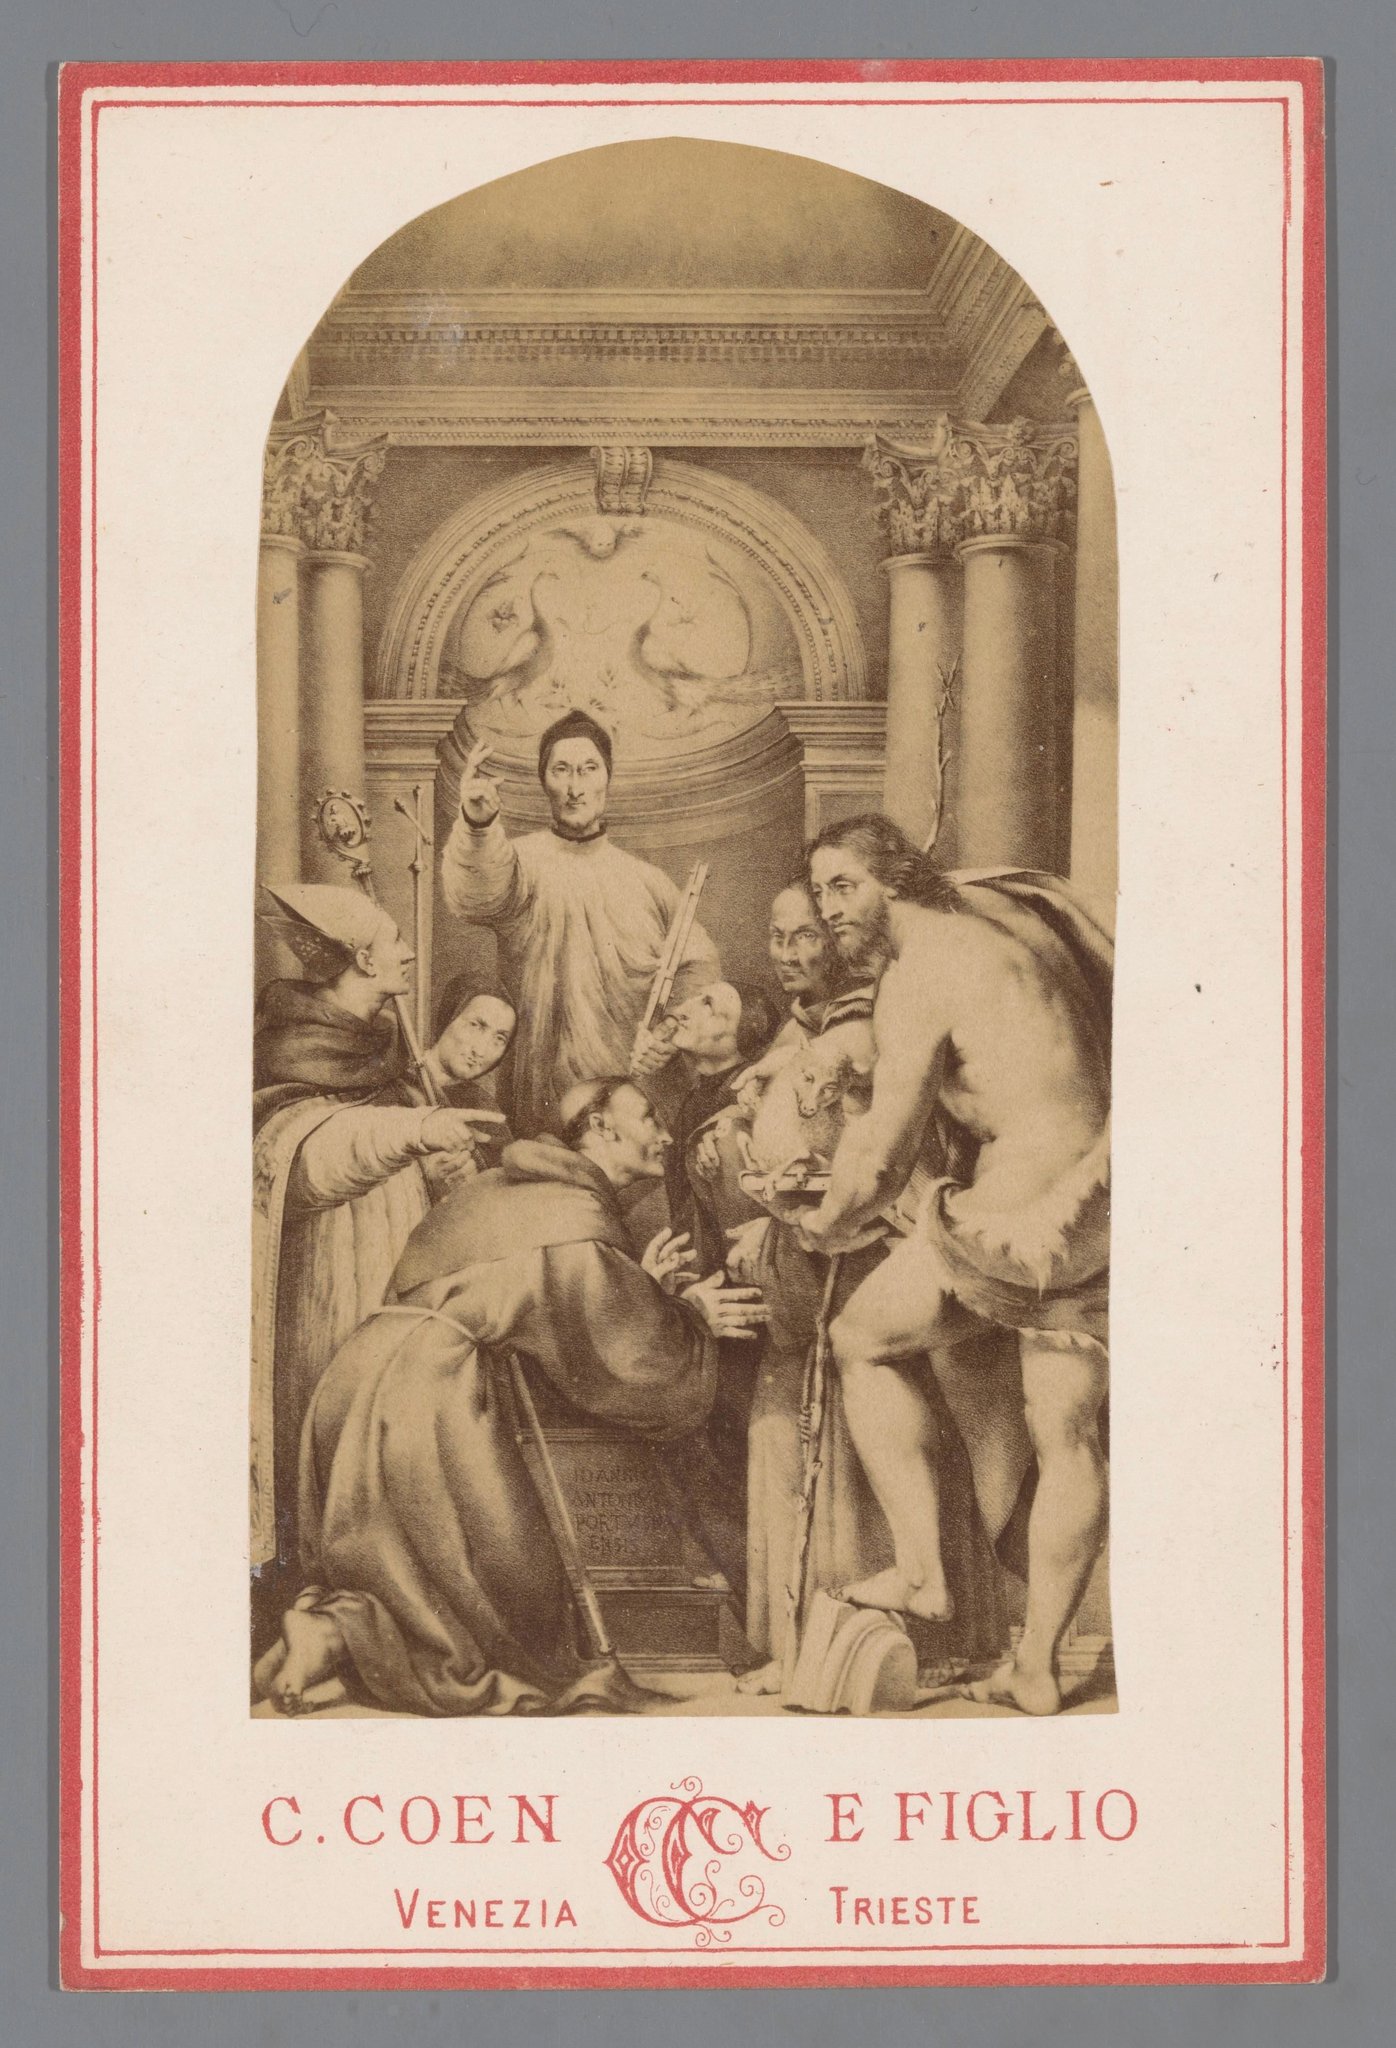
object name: cabinet photograph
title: Fotoreproductie van een tekening naar een schilderij van heiligen door Il Pordenone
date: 1870-1900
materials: cardboard, photographic support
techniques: albumen print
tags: saints, picture, painting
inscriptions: inscription: ‘22 25 40 S. Lorenzo [...] Pordenone’